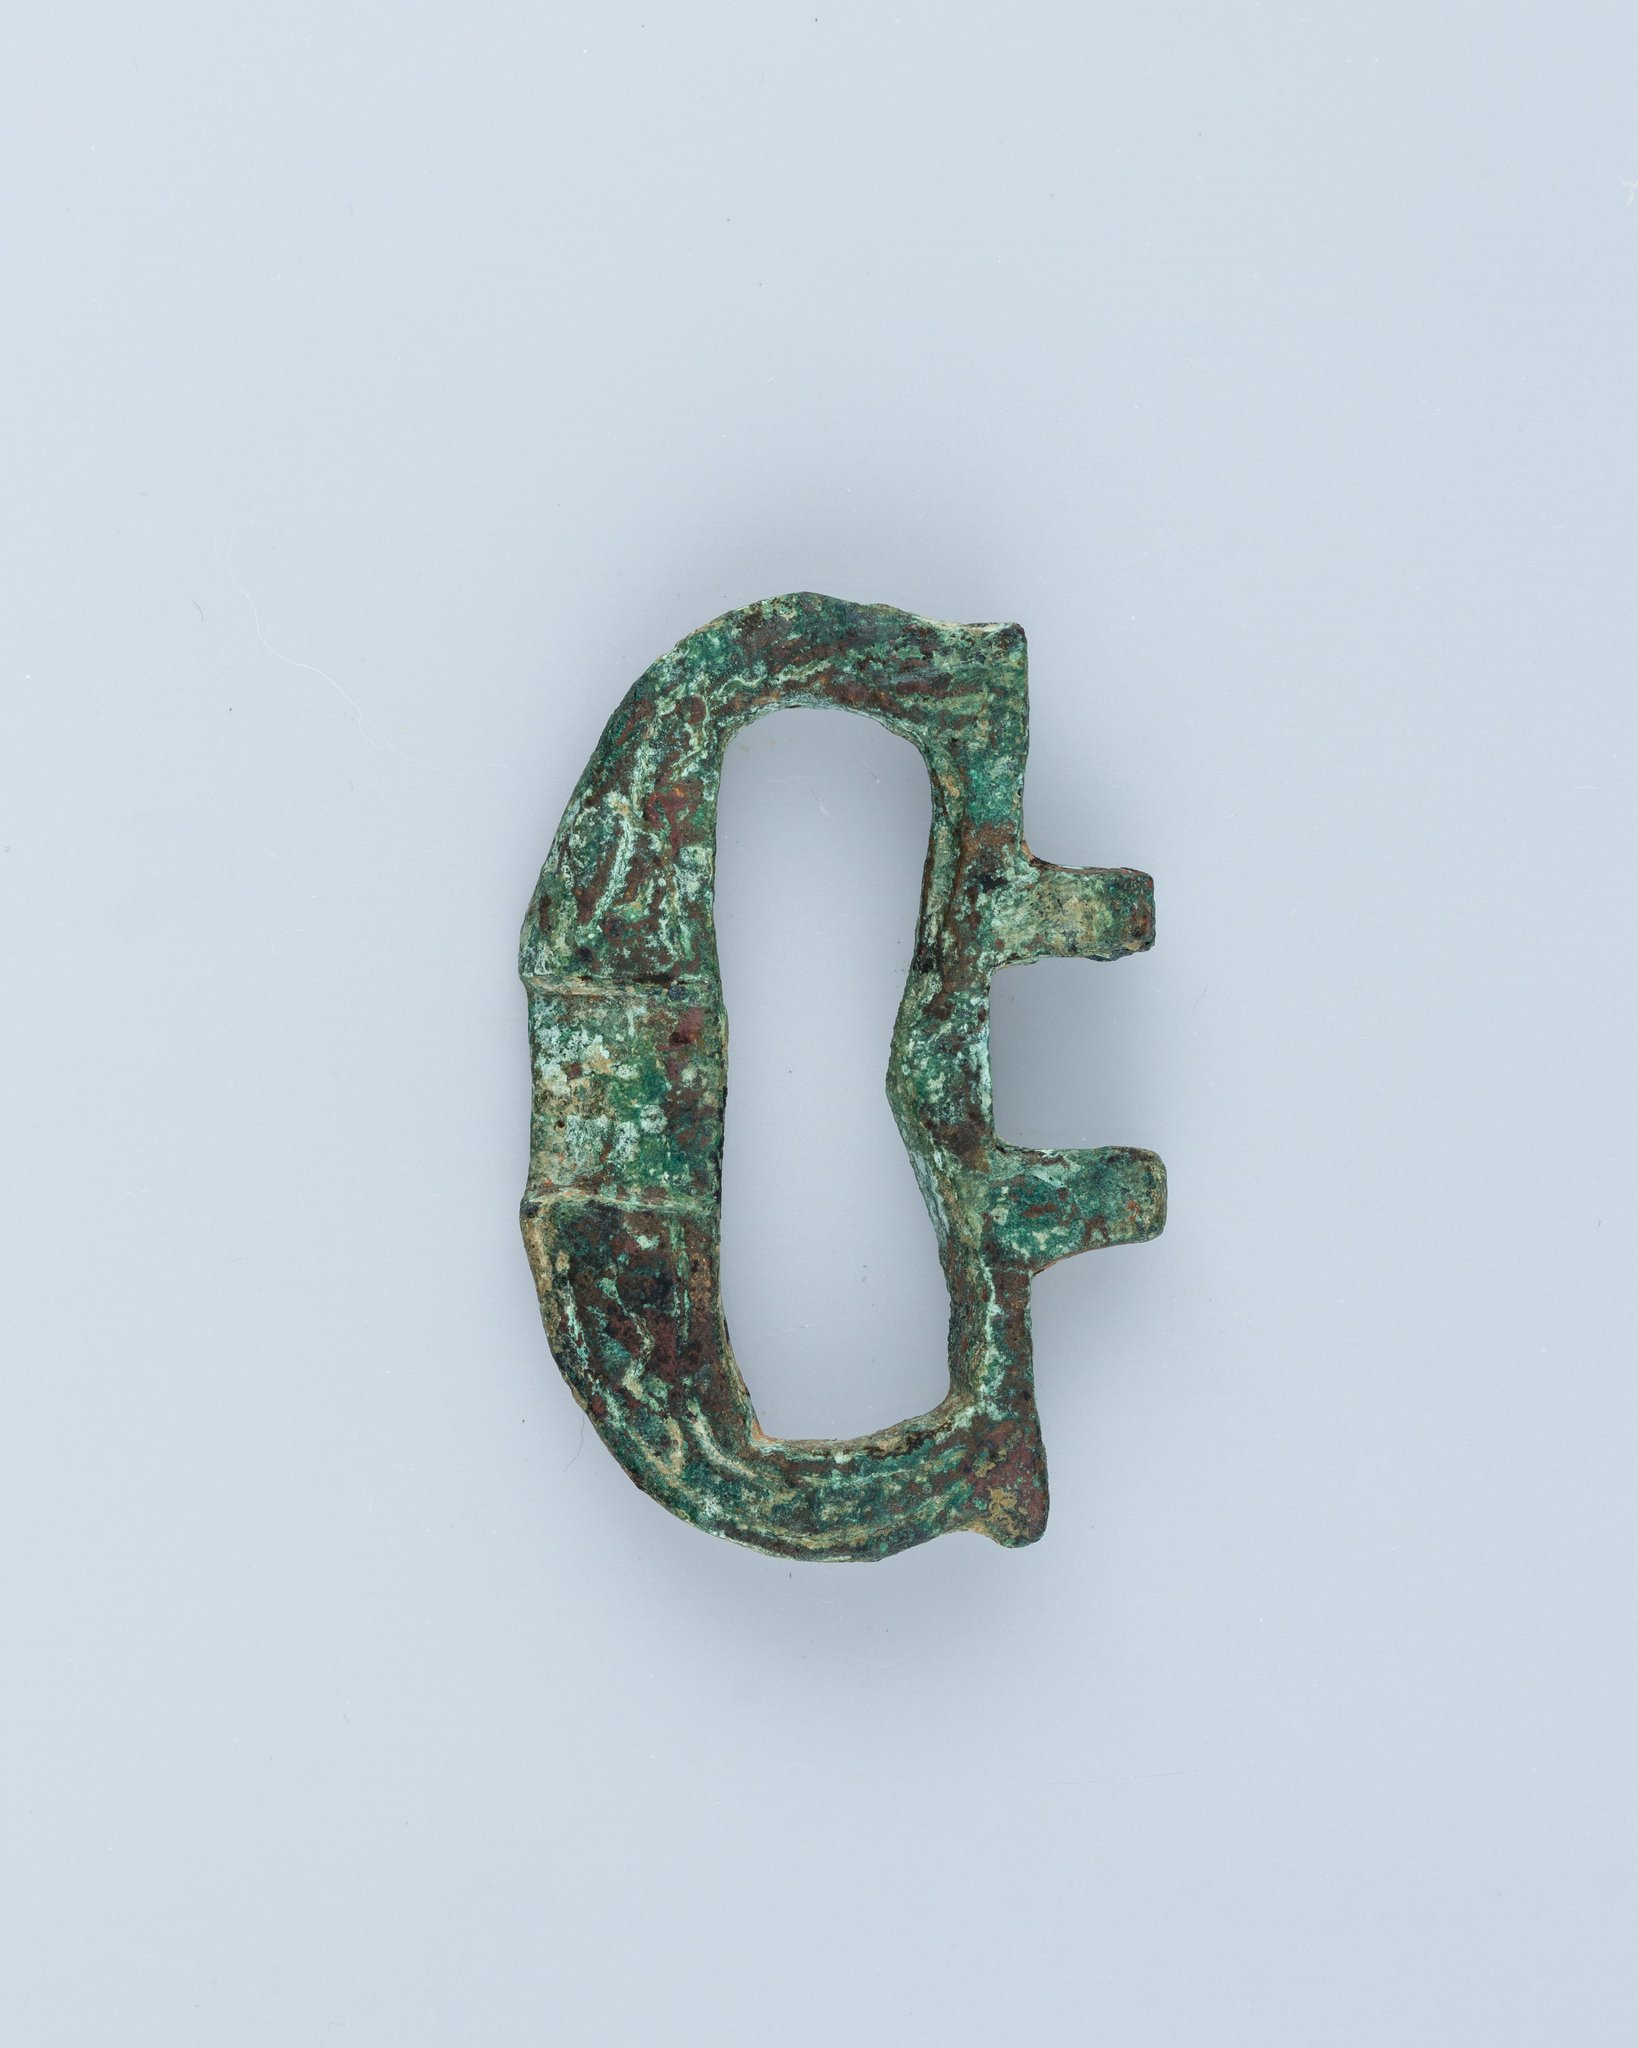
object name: buckle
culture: ibero-roman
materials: bronze, patina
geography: spain or portugal